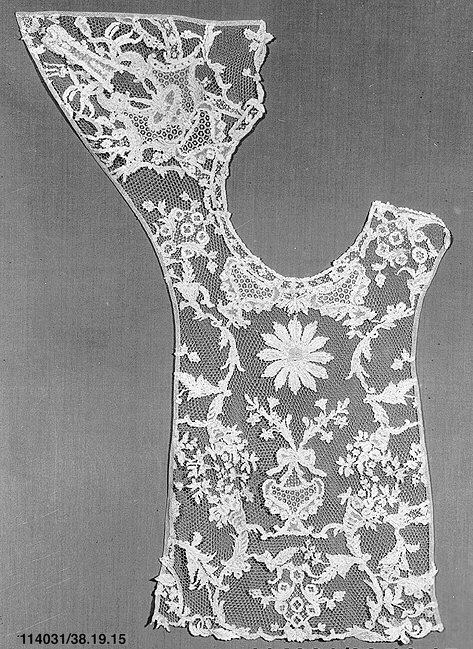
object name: gilet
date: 1701-1800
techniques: lace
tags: flowers